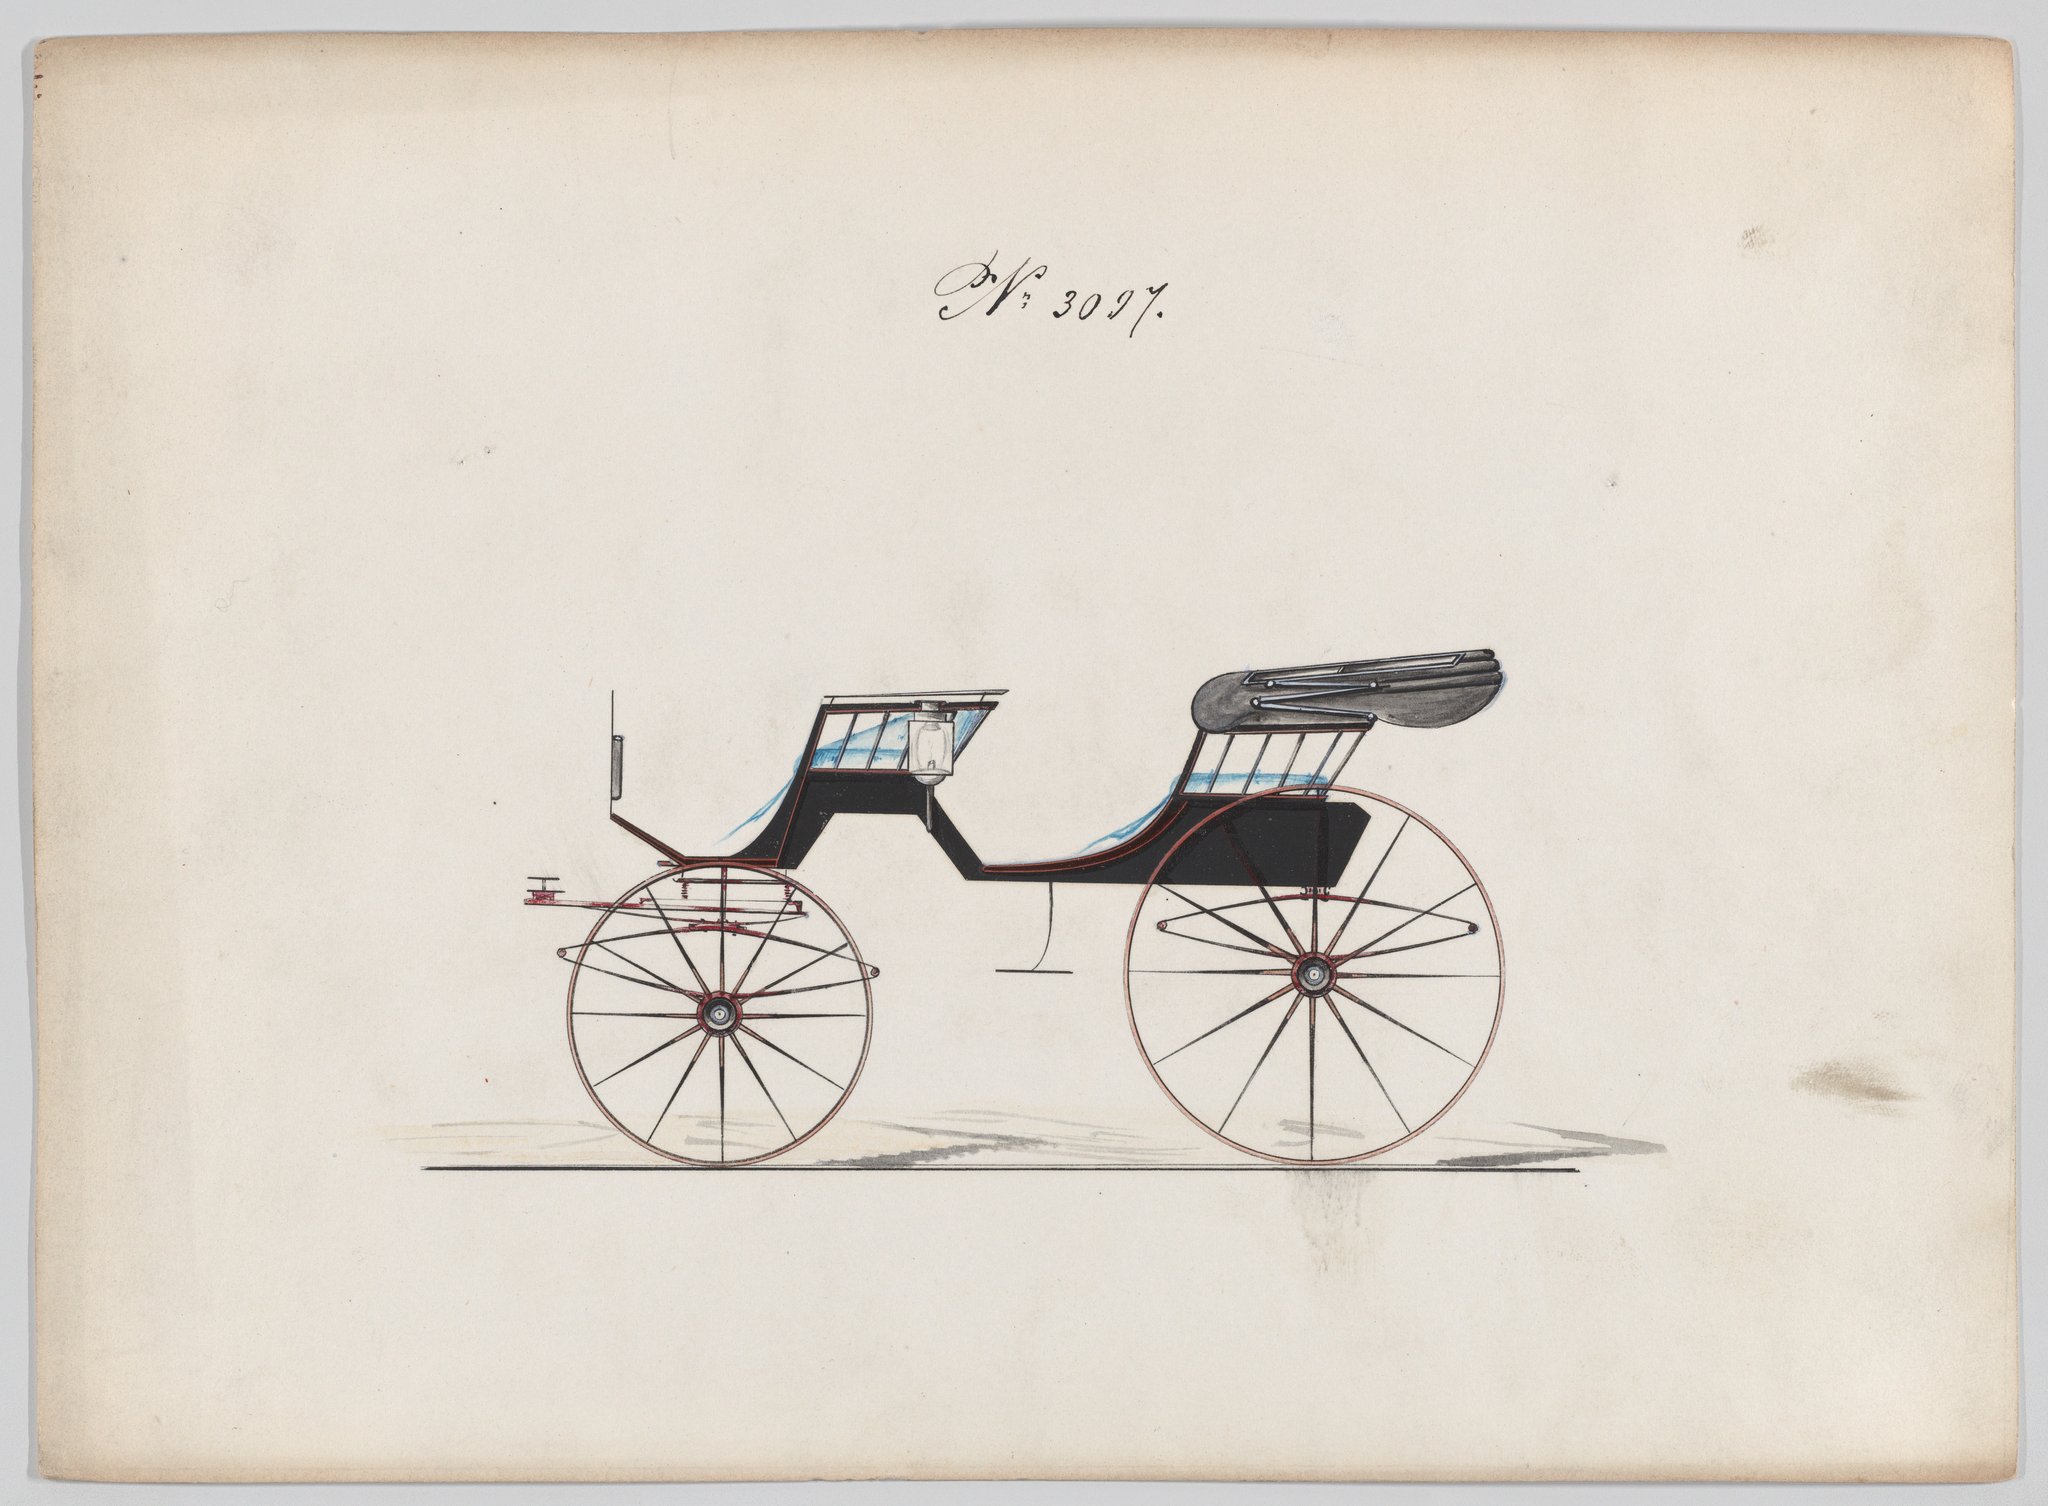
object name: drawing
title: Design for 2 seat Phaeton, no. 3097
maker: brewster & co.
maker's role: manufacturer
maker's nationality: american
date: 1875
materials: gouache, watercolor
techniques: pen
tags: carriages